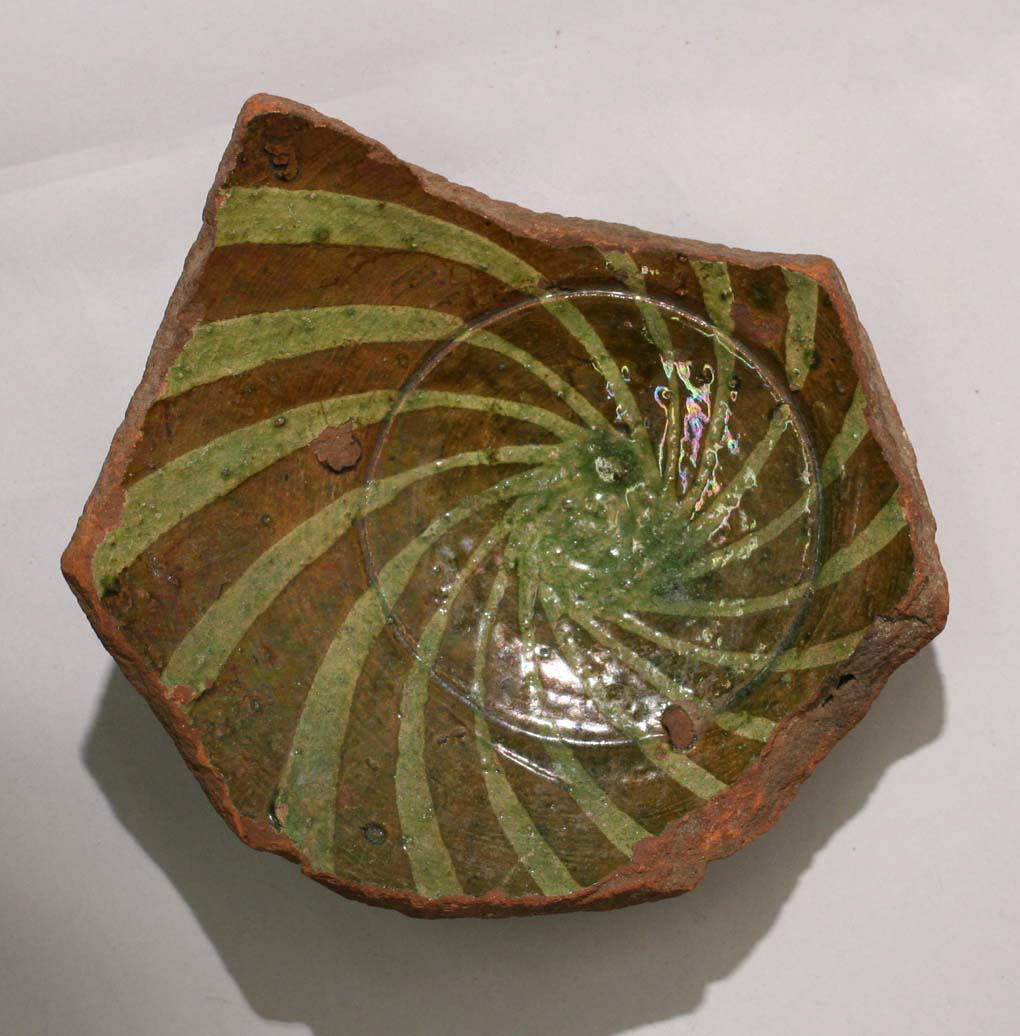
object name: ceramic fragment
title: Fragment of a Bowl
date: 1301-1500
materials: earthenware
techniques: glazing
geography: egypt